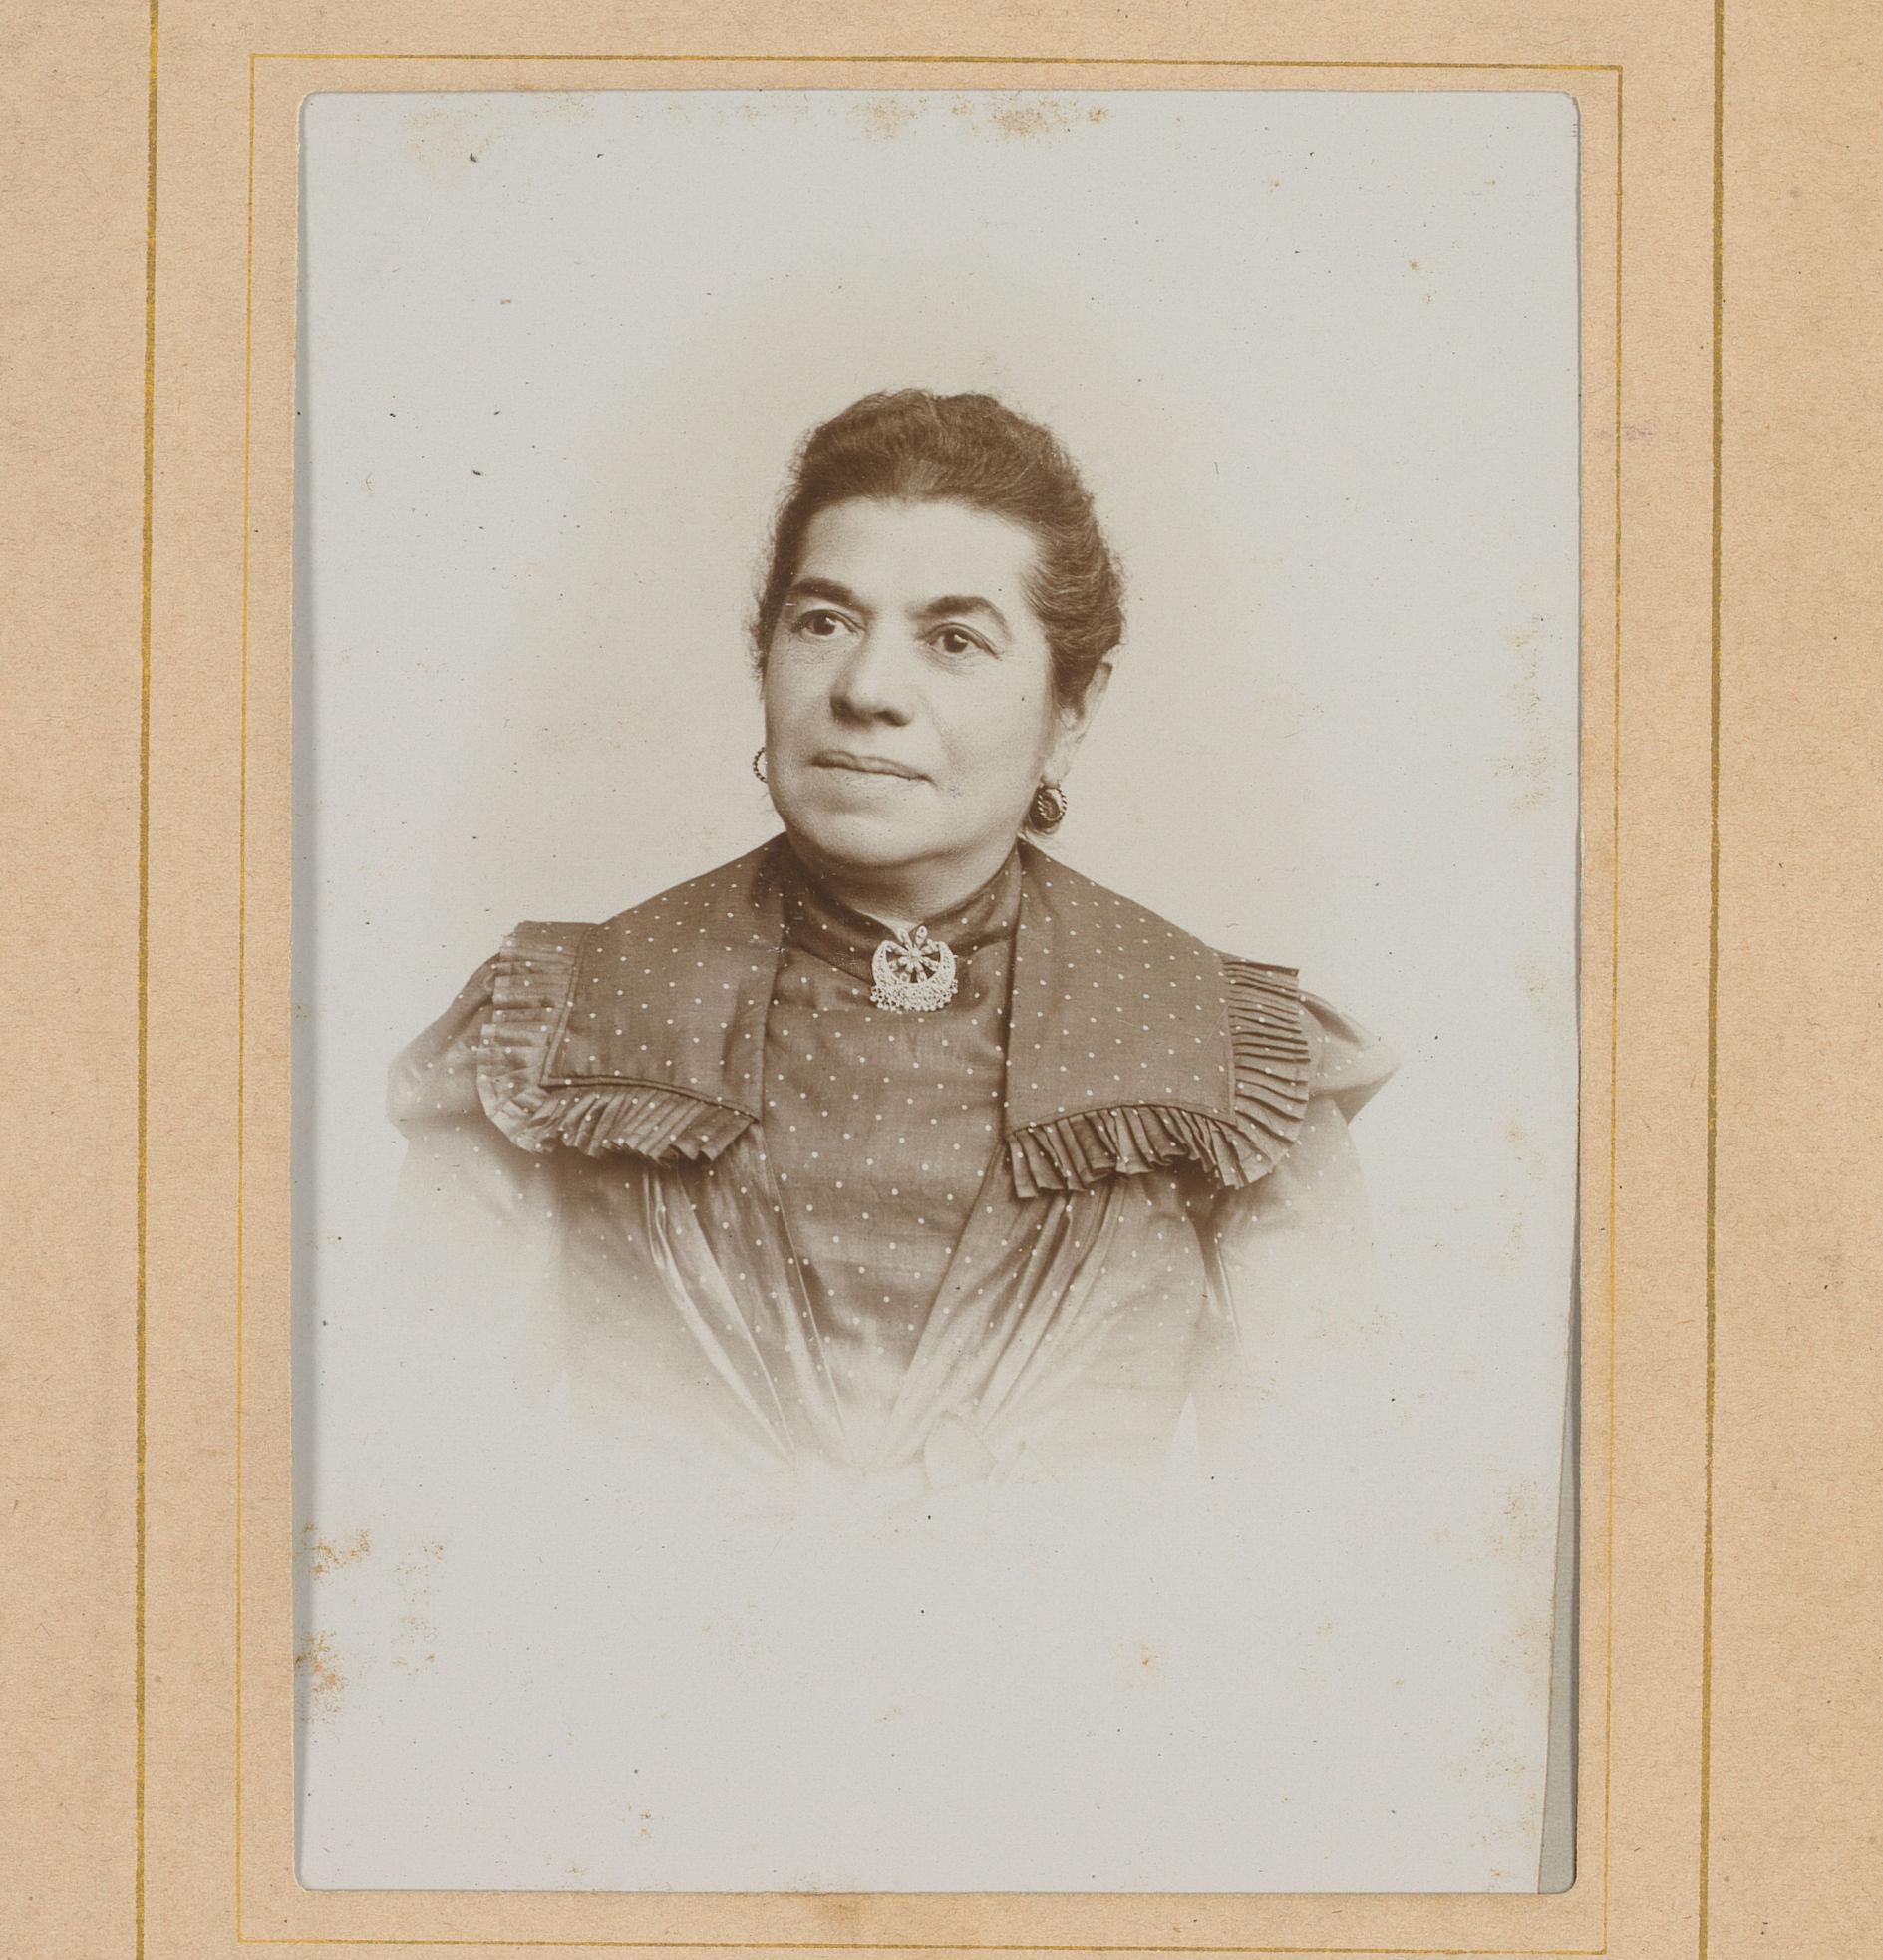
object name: photograph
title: Portret van een vrouw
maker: jacques prévot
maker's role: fotograaf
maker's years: 1857-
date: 1870-1900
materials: cardboard, photographic support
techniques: collodion silver print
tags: adult woman, historical persons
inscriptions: name: ‘6, Rue de l'Offrande J. Prévot/Anvers’, inscription: ‘Photographie/ J. Prévot/ 6, Rue de l'Offrande/ coin de la rue Dambrugge/ Anvers’